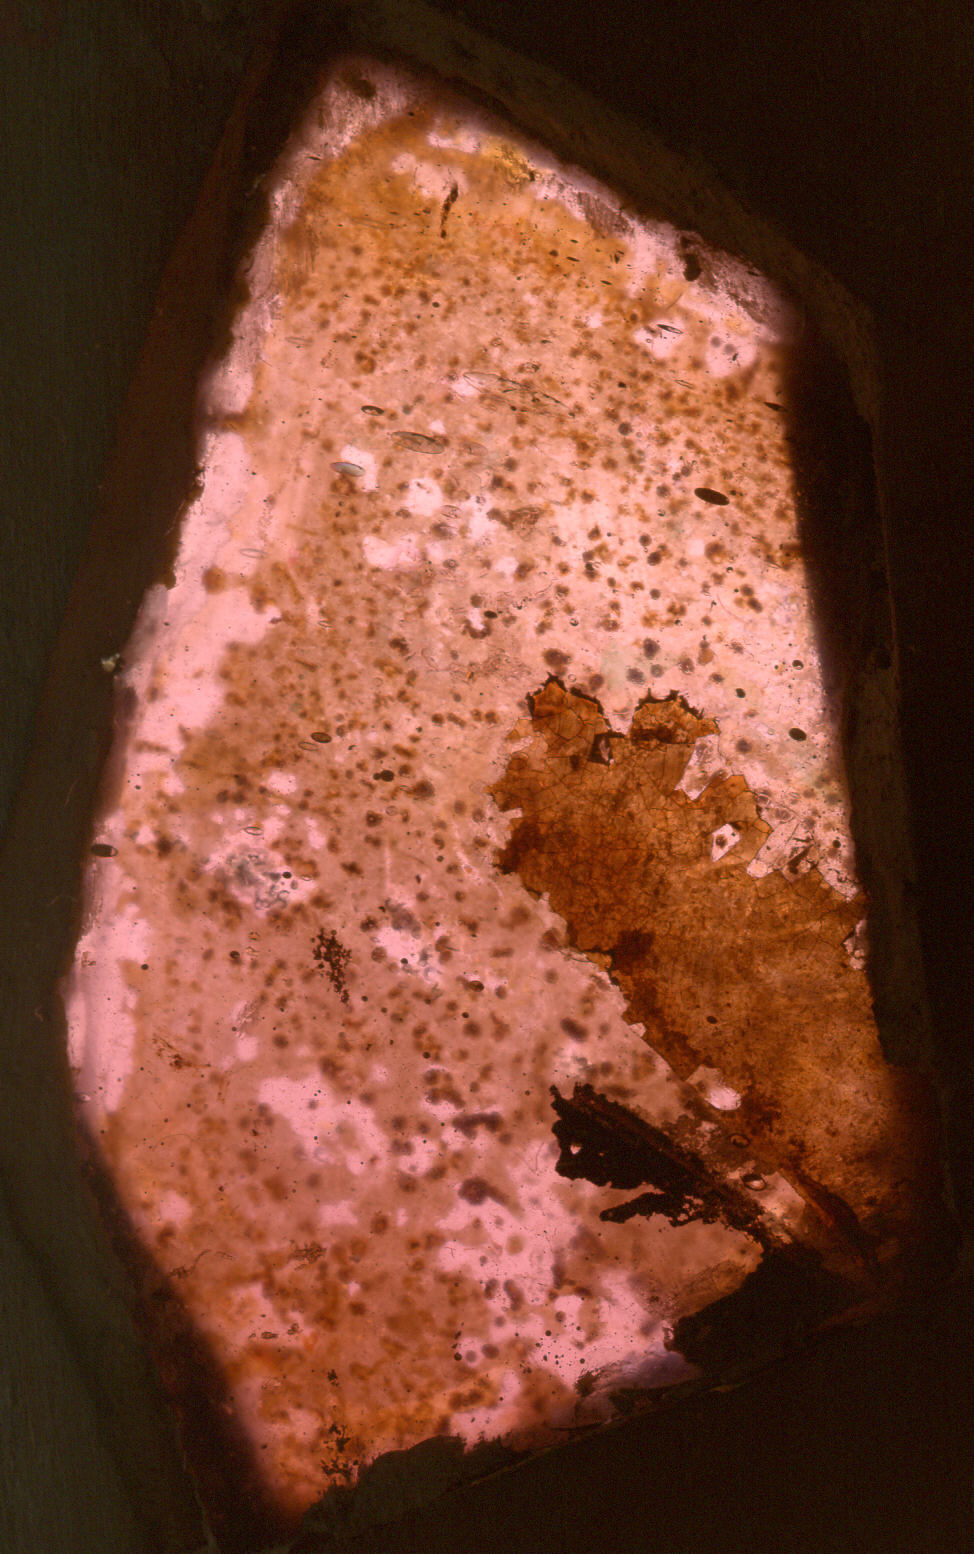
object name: fragment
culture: crusader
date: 1201-1300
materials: glass